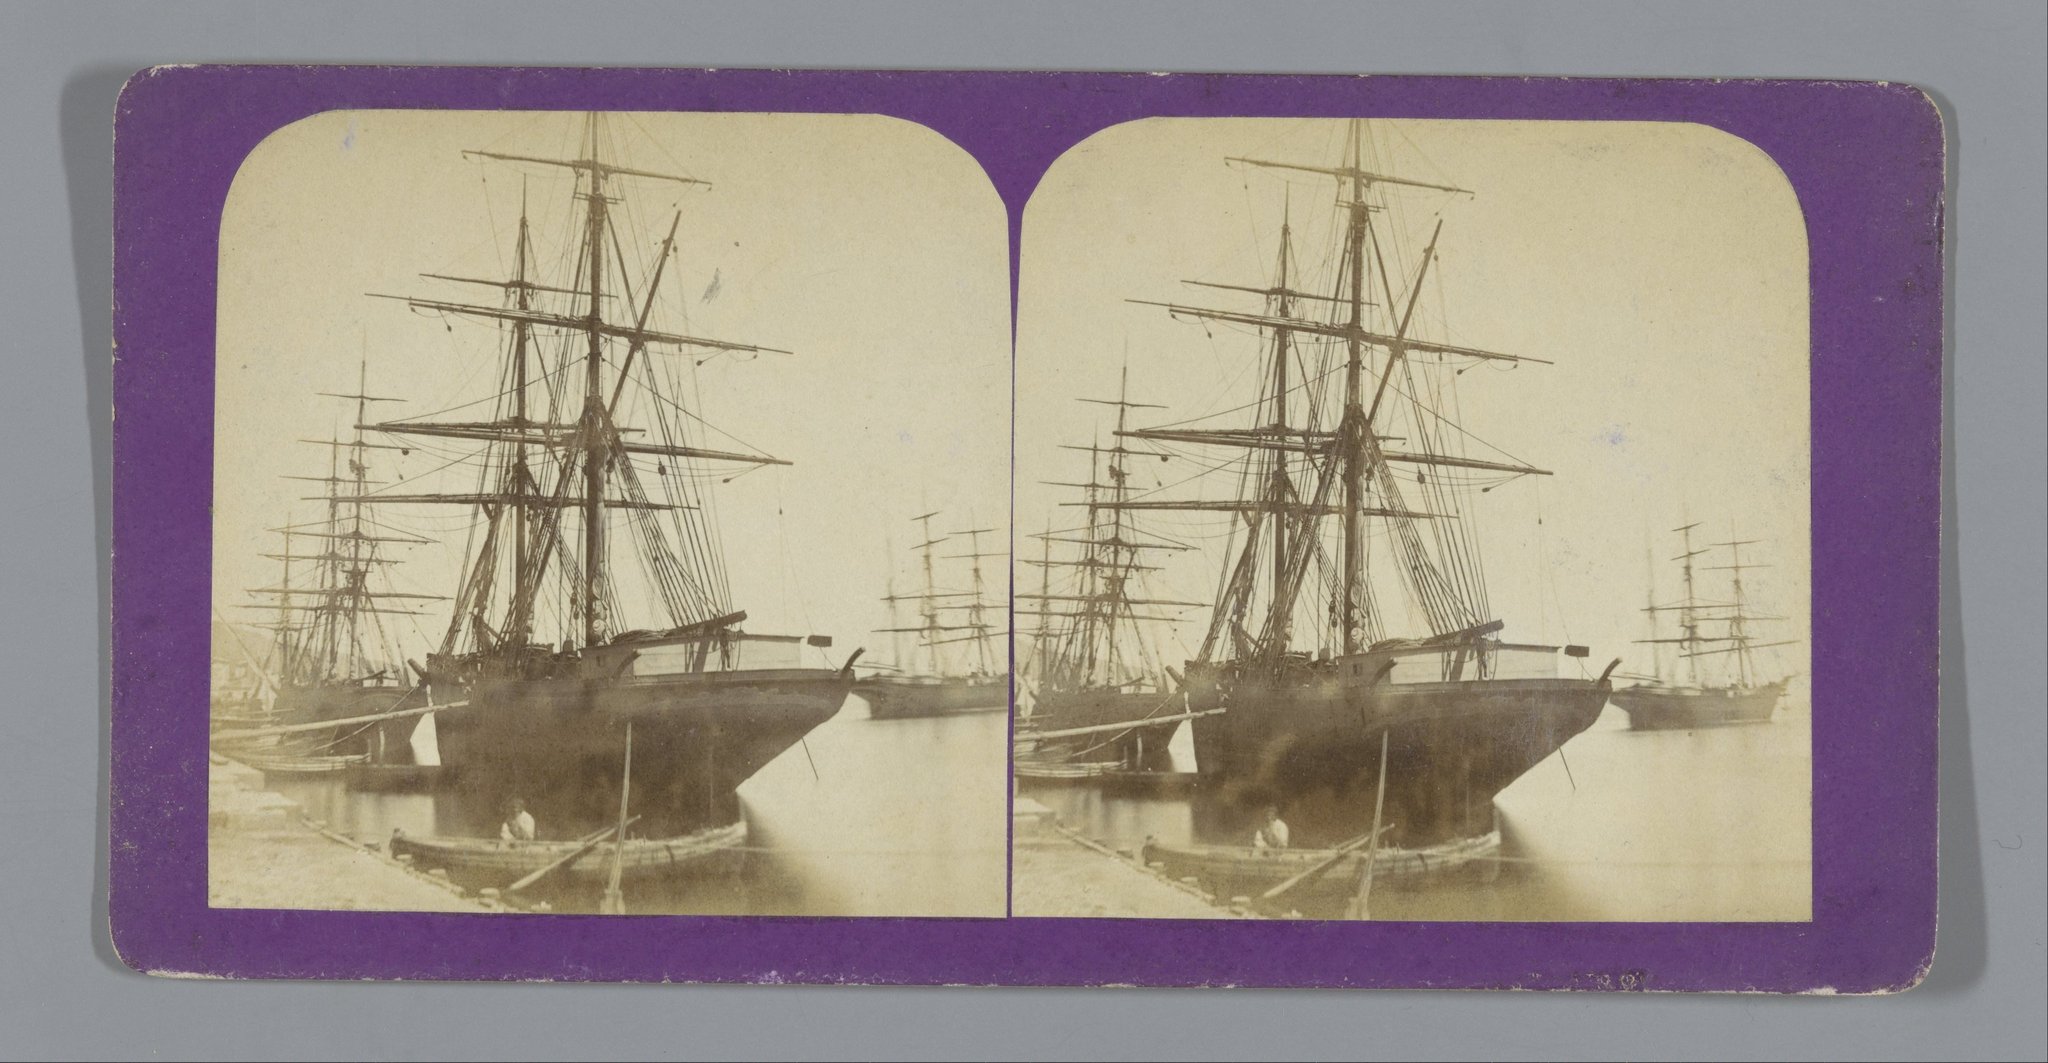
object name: stereograph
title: Gezicht op een schip in de haven van Messina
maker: jean andrieu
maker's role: fotograaf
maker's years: 1816-1872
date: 1862-1876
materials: cardboard, paper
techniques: albumen print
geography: messina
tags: harbour, ships (in general)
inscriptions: title: ‘1441 Le Port (Messine)’